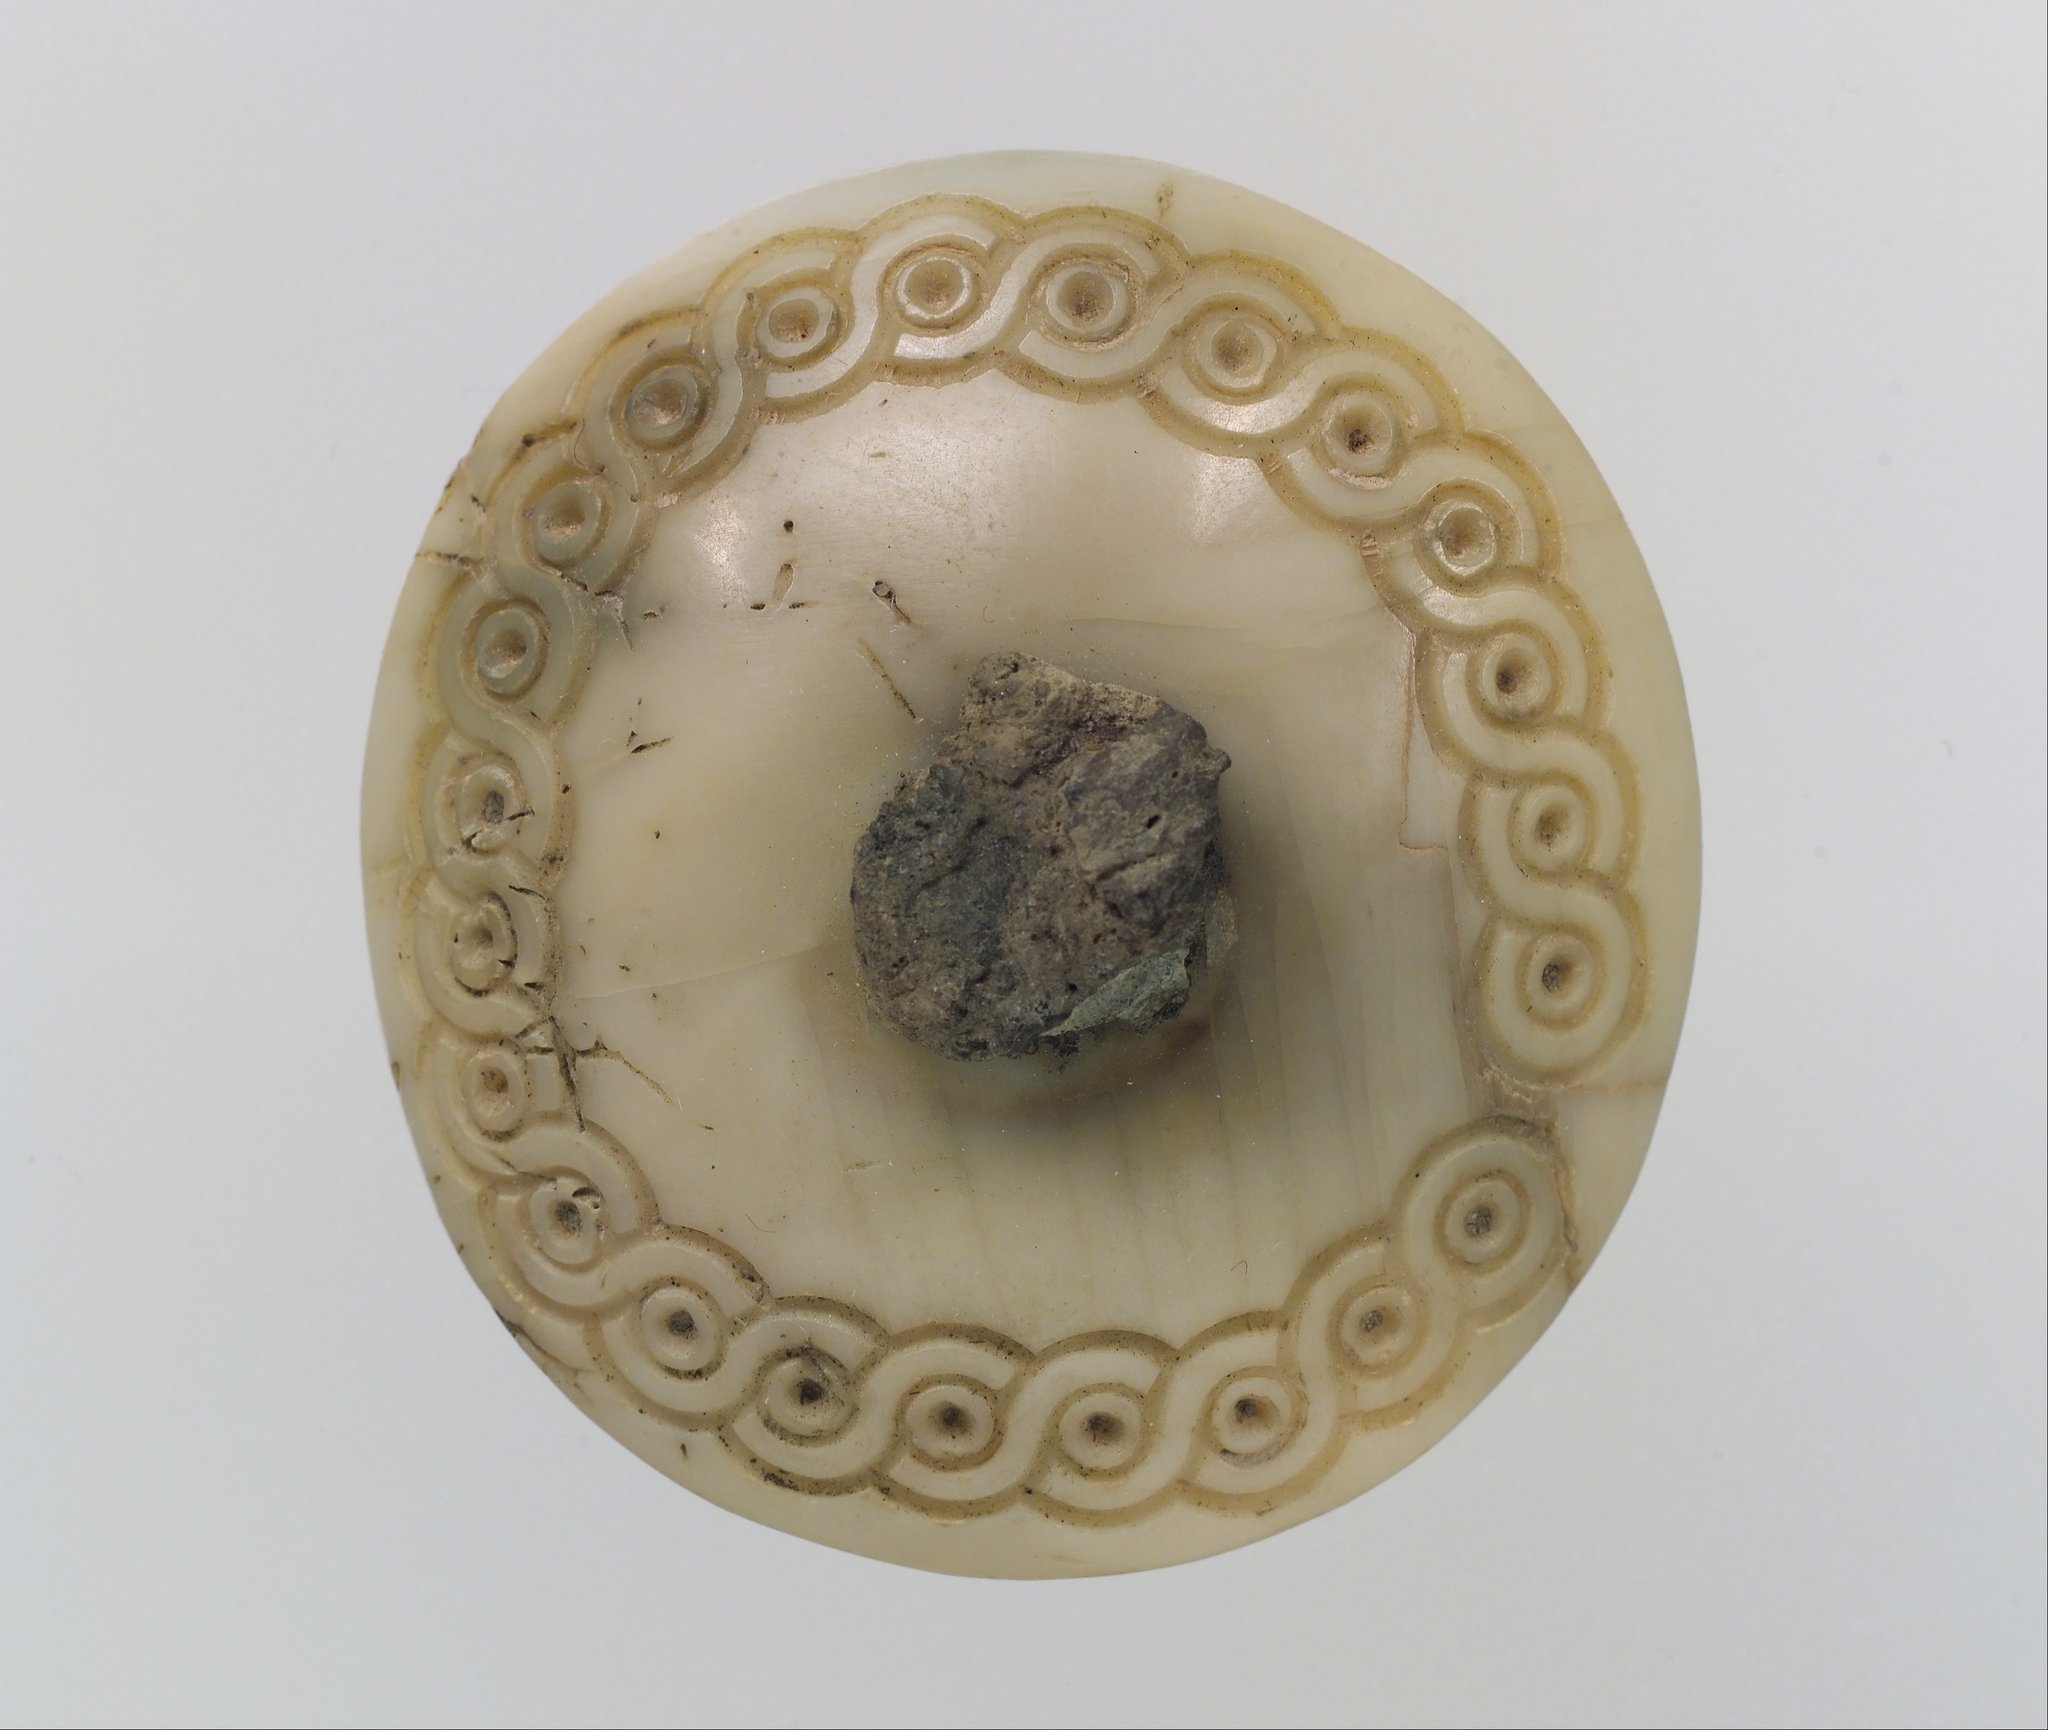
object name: bos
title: Decorative boss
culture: assyrian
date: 800-701 BCE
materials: shell, silver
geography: mesopotamia